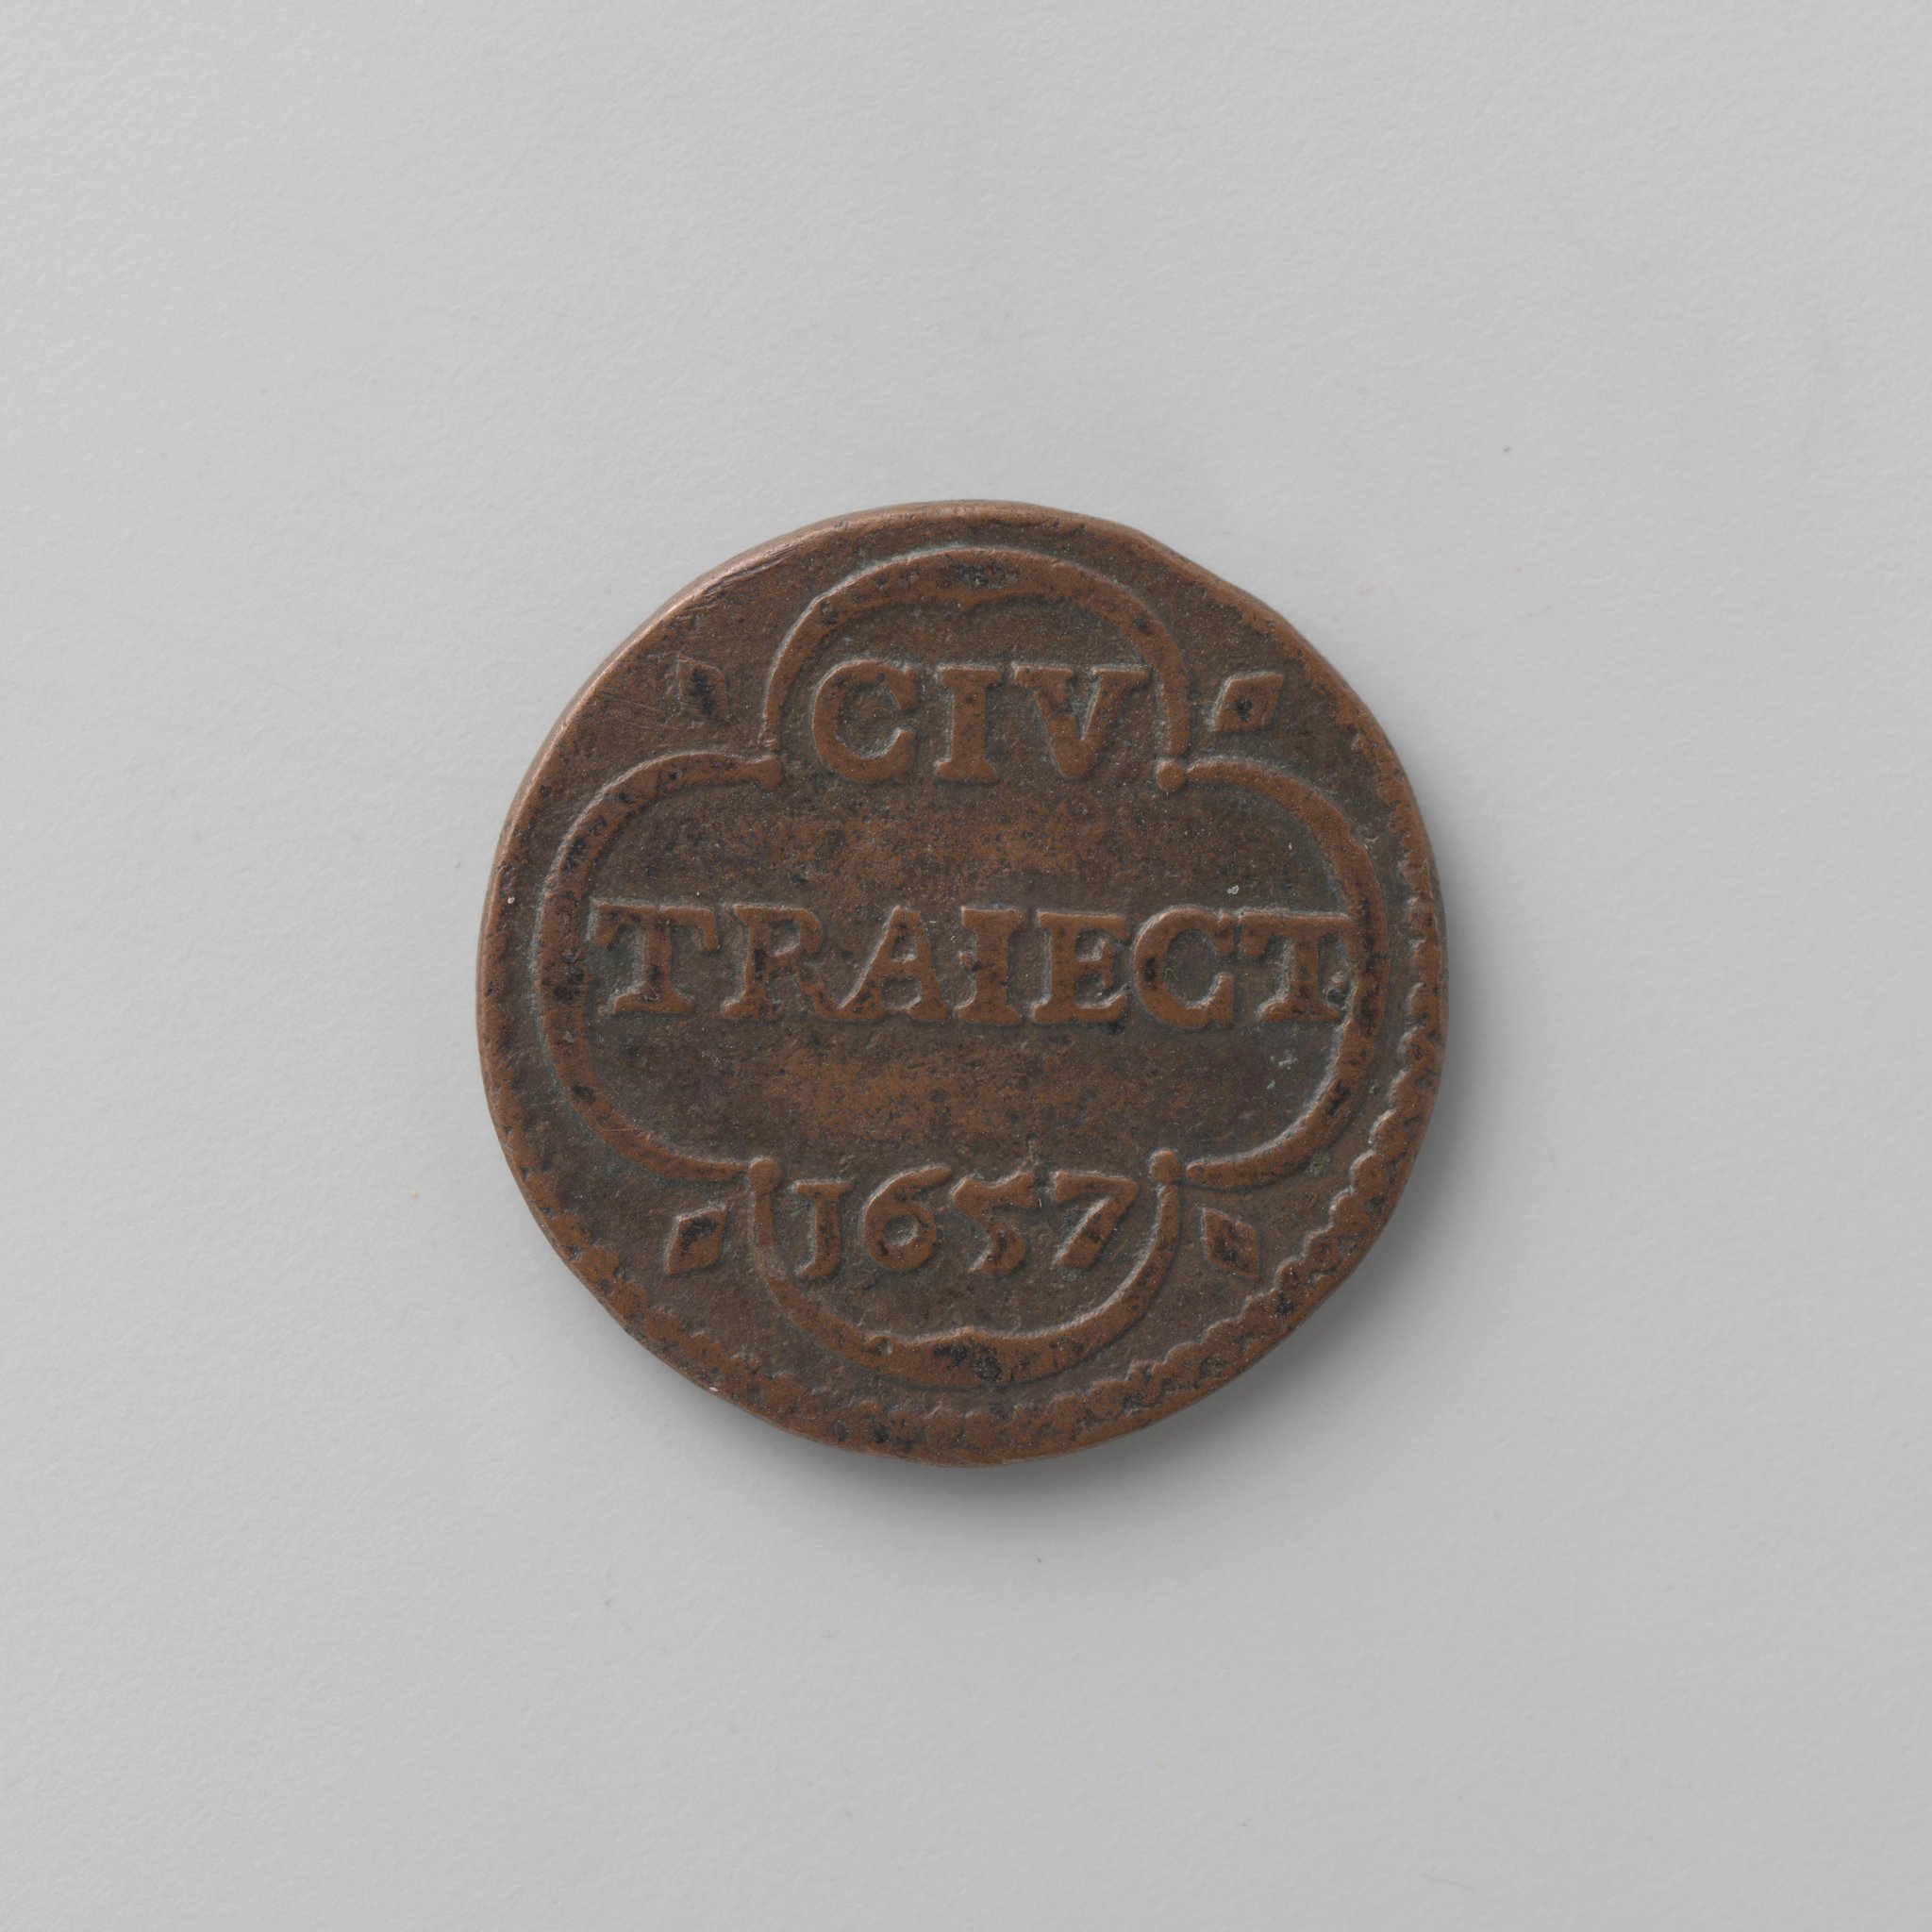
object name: coin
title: Stad Utrecht, duit, 1657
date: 1657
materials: copper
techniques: striking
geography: utrecht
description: Koperen munt. Voorzijde: gekroond stedelijk wapenschild, gehouden door twee leeuwen. Keerzijde: binnen een versierde vierpas opschrift in twee regels, waaronder jaartal.